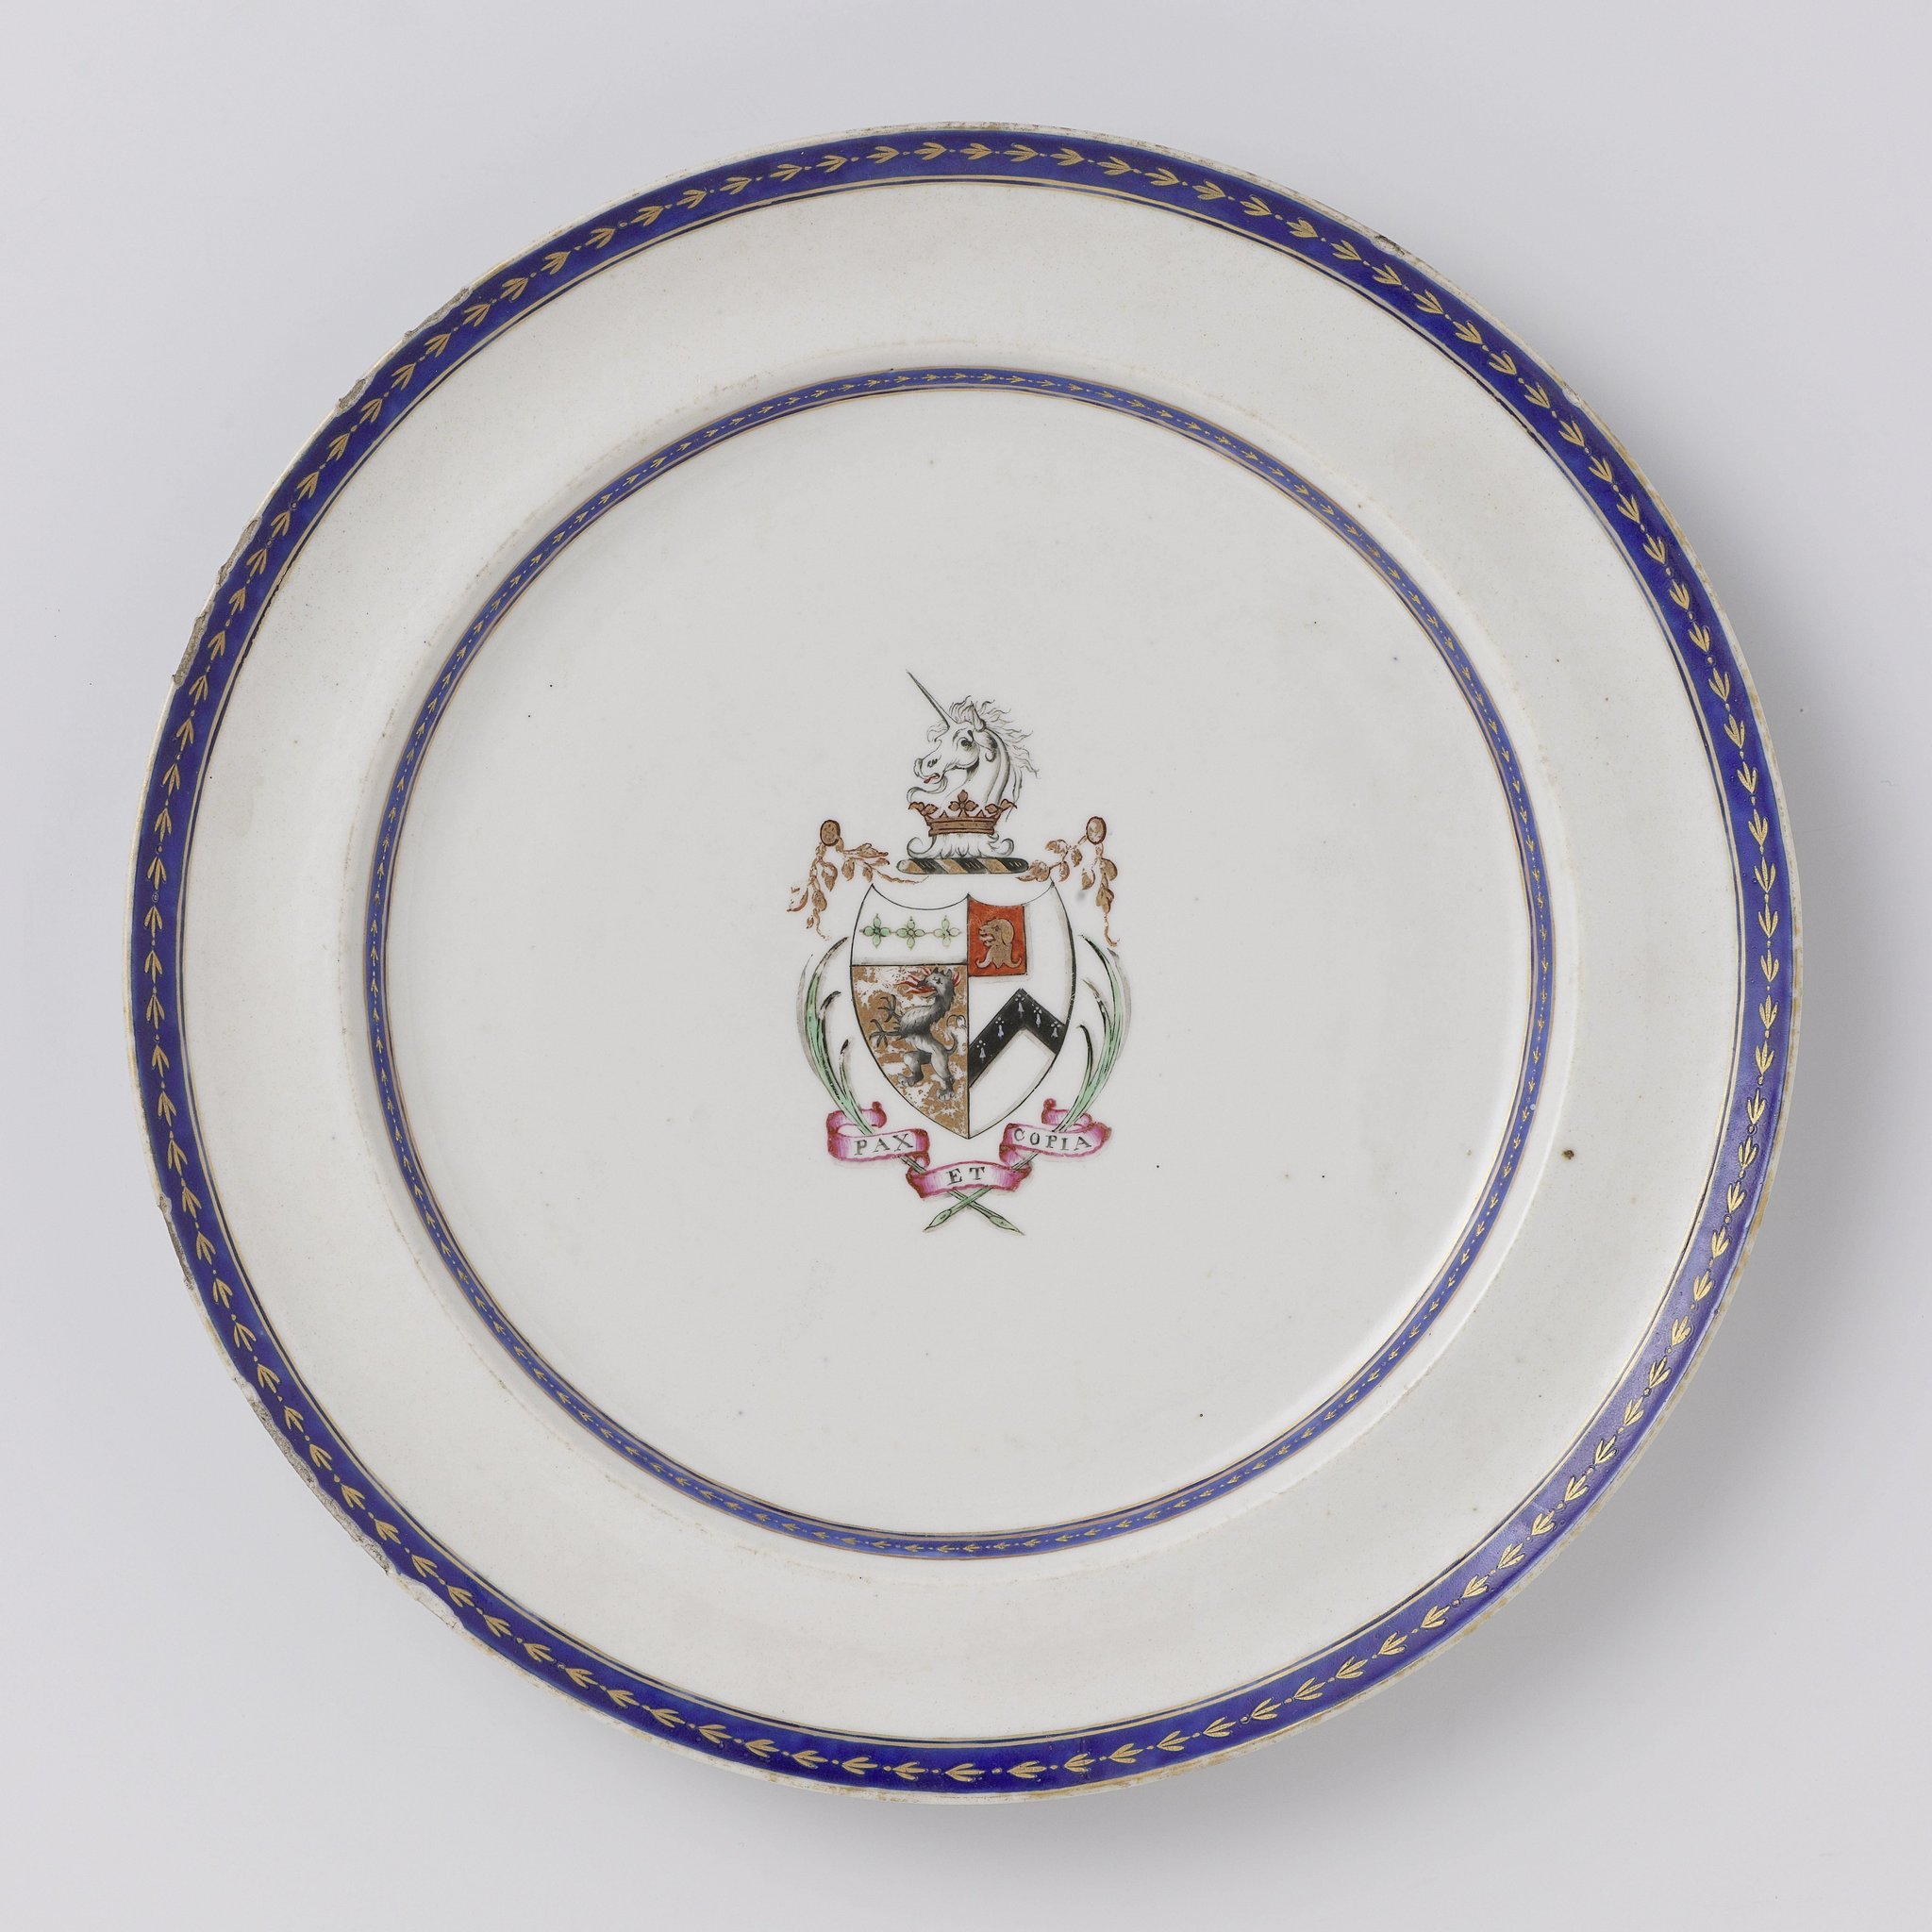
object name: plate dish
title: Plate with the arms of the Samler and Shaw family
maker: Anonymous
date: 1775-1799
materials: glaze, gold, paint, porcelain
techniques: firing, gilding, turning, vitrification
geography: china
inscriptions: inscription: ‘PAX ET COPIA’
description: Bord van porselein, beschilderd op het glazuur in blauw, rood, roze, groen, zwart en goud. Op het plat het wapen van de families Samler en Shaw met een griffioen en een leeuw. Het helmteken is een eenhoorn. Om het wapen twee palmtakken en eronder een banderol met het opschrift 'PAX ET COPIA', 'Vrede en Overvloed'; op de wand en rand een decoratieve band. Enkele chips in de rand. Wapenporselein met emailkleuren.